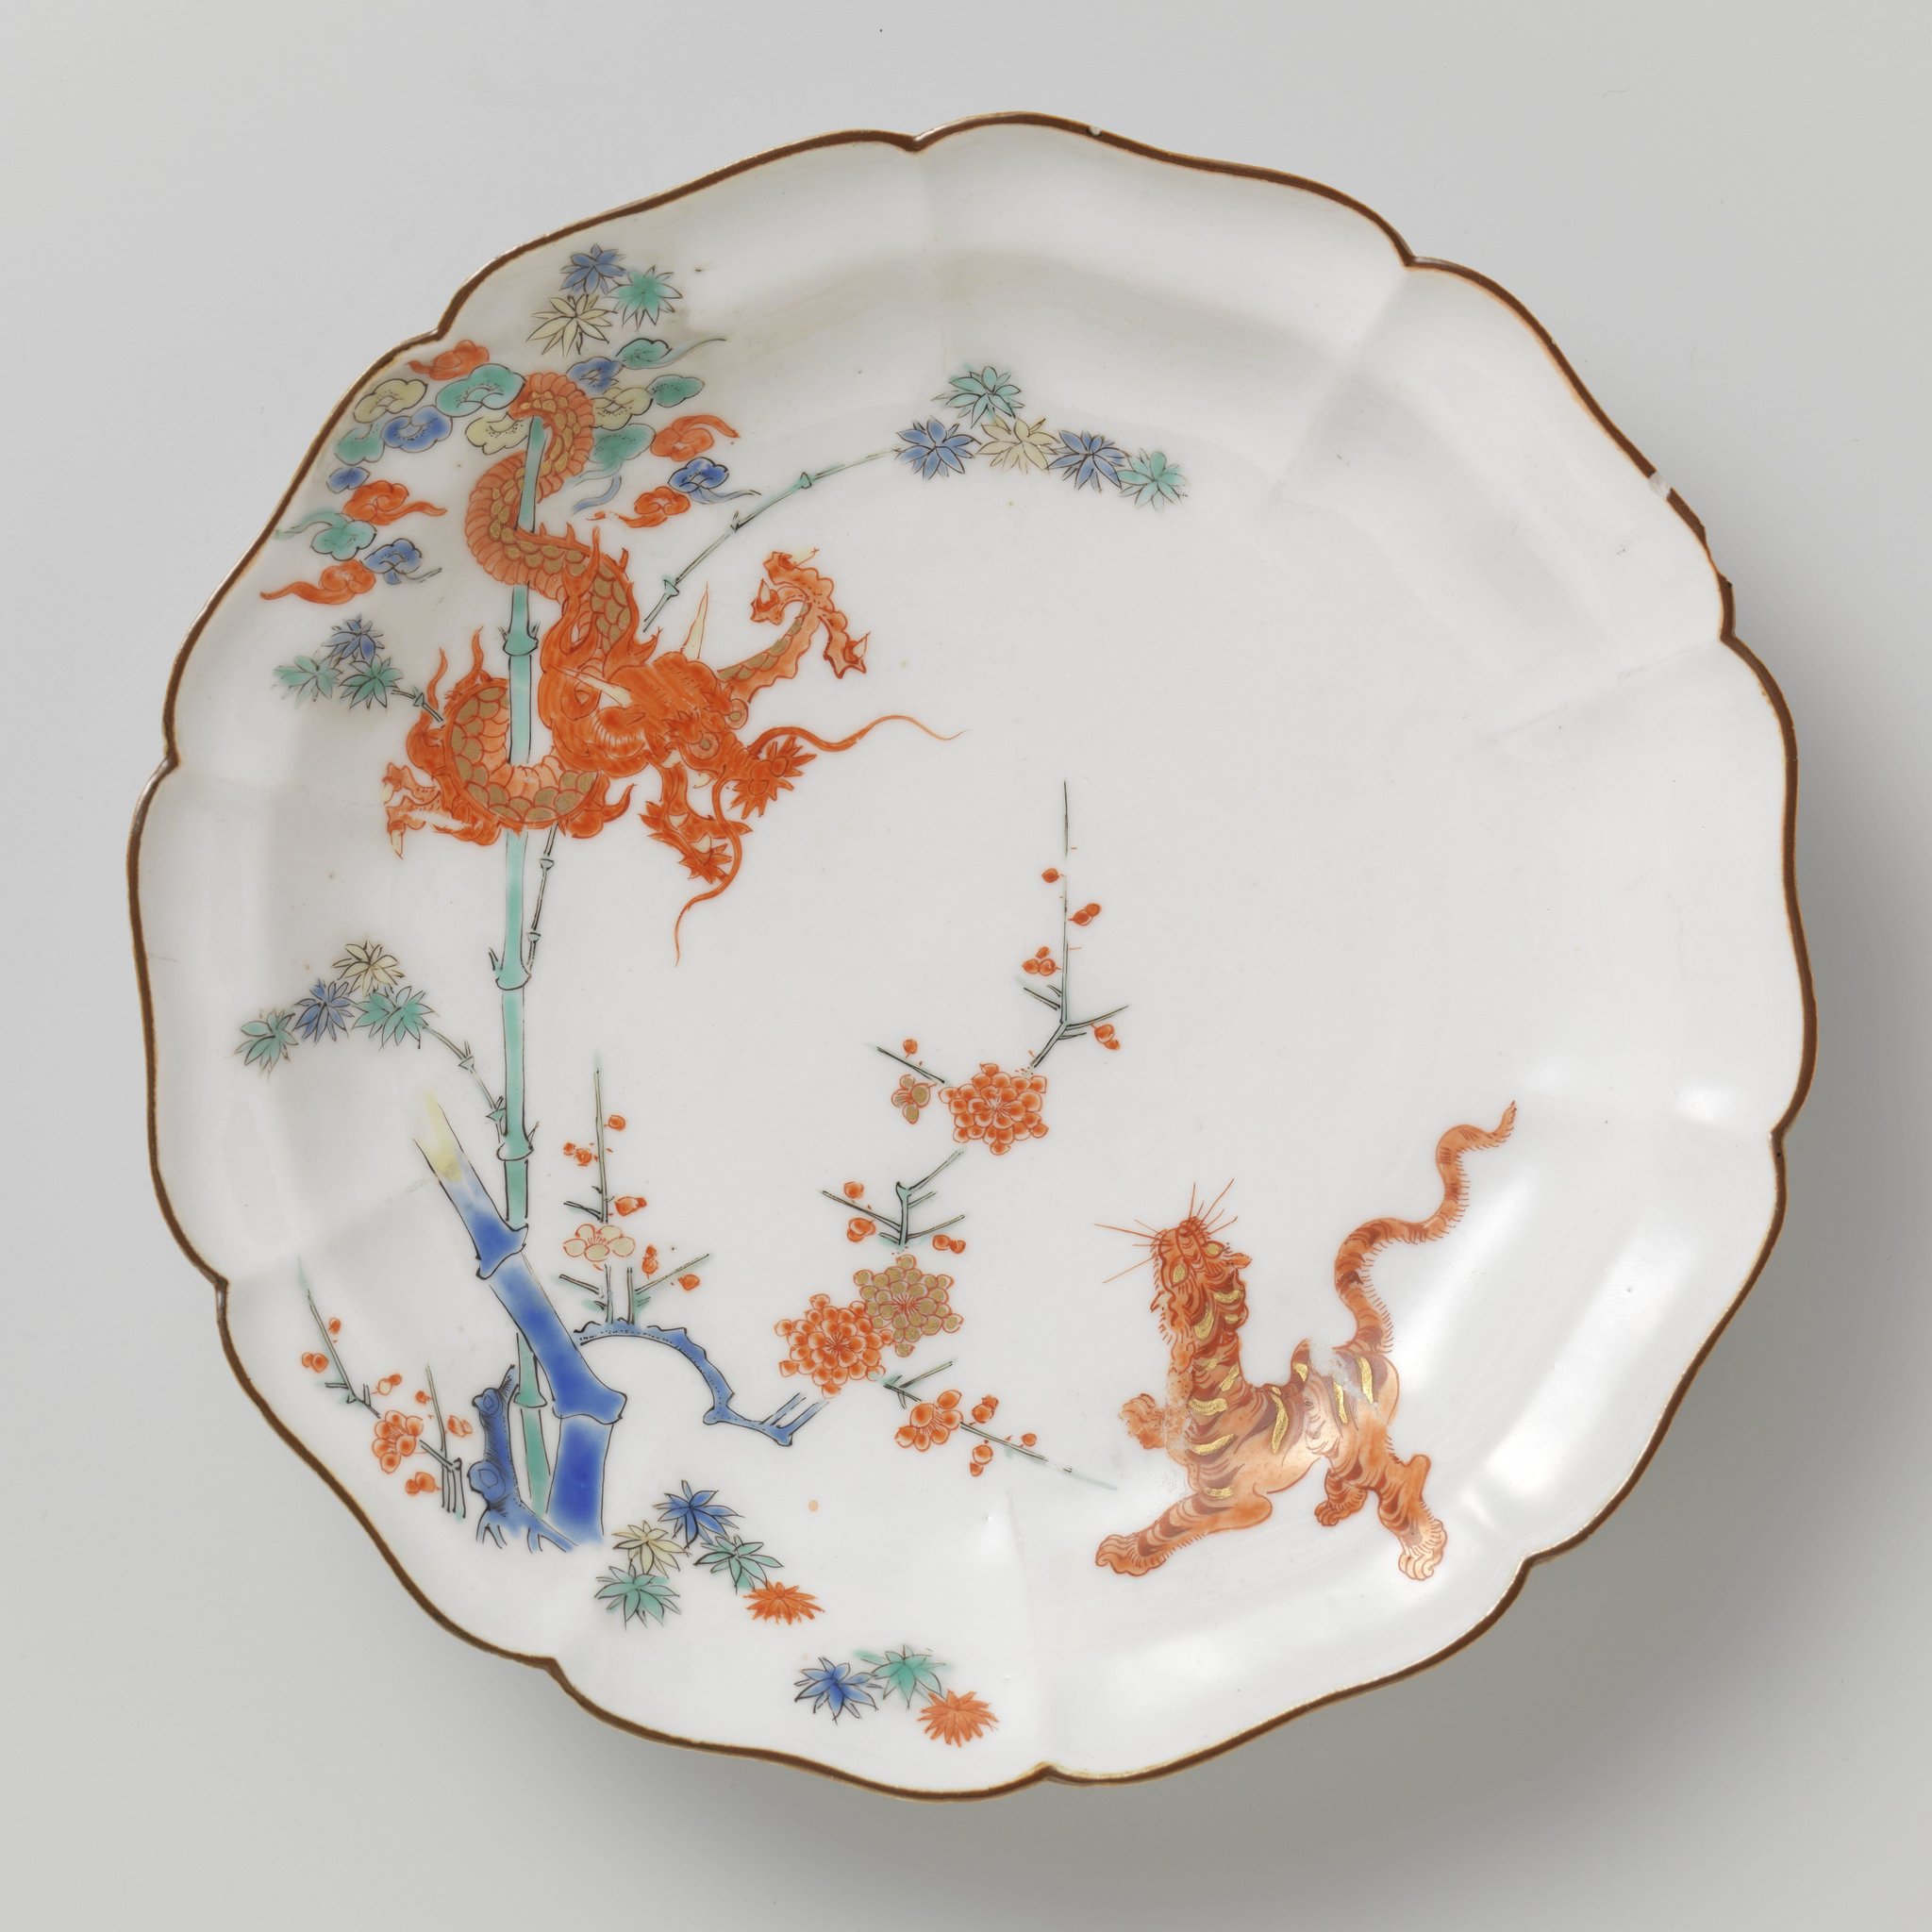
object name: plate dish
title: Lobed dish with dragon, tiger, bamboo and prunus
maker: Anonymous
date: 1670-1690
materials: glaze, gold, paint, porcelain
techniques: forming, gilding, turning, vitrification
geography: arita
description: Dish, c. 1690 - 1725.